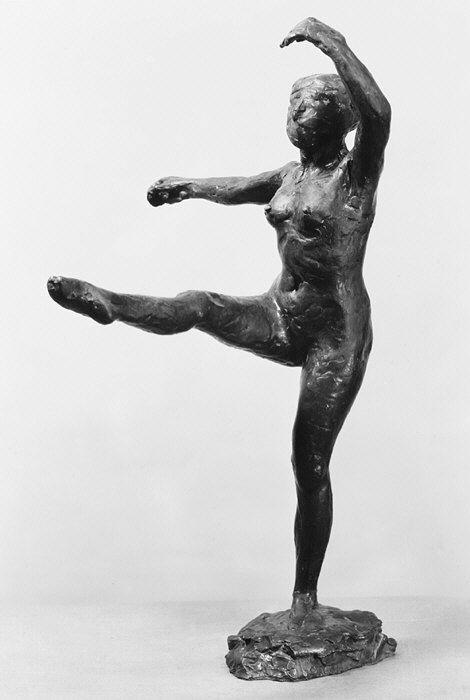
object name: statuette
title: Arabesque Devant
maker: edgar degas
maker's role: artist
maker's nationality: french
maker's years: 1834-1917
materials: bronze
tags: female nudes,dancers,ballet